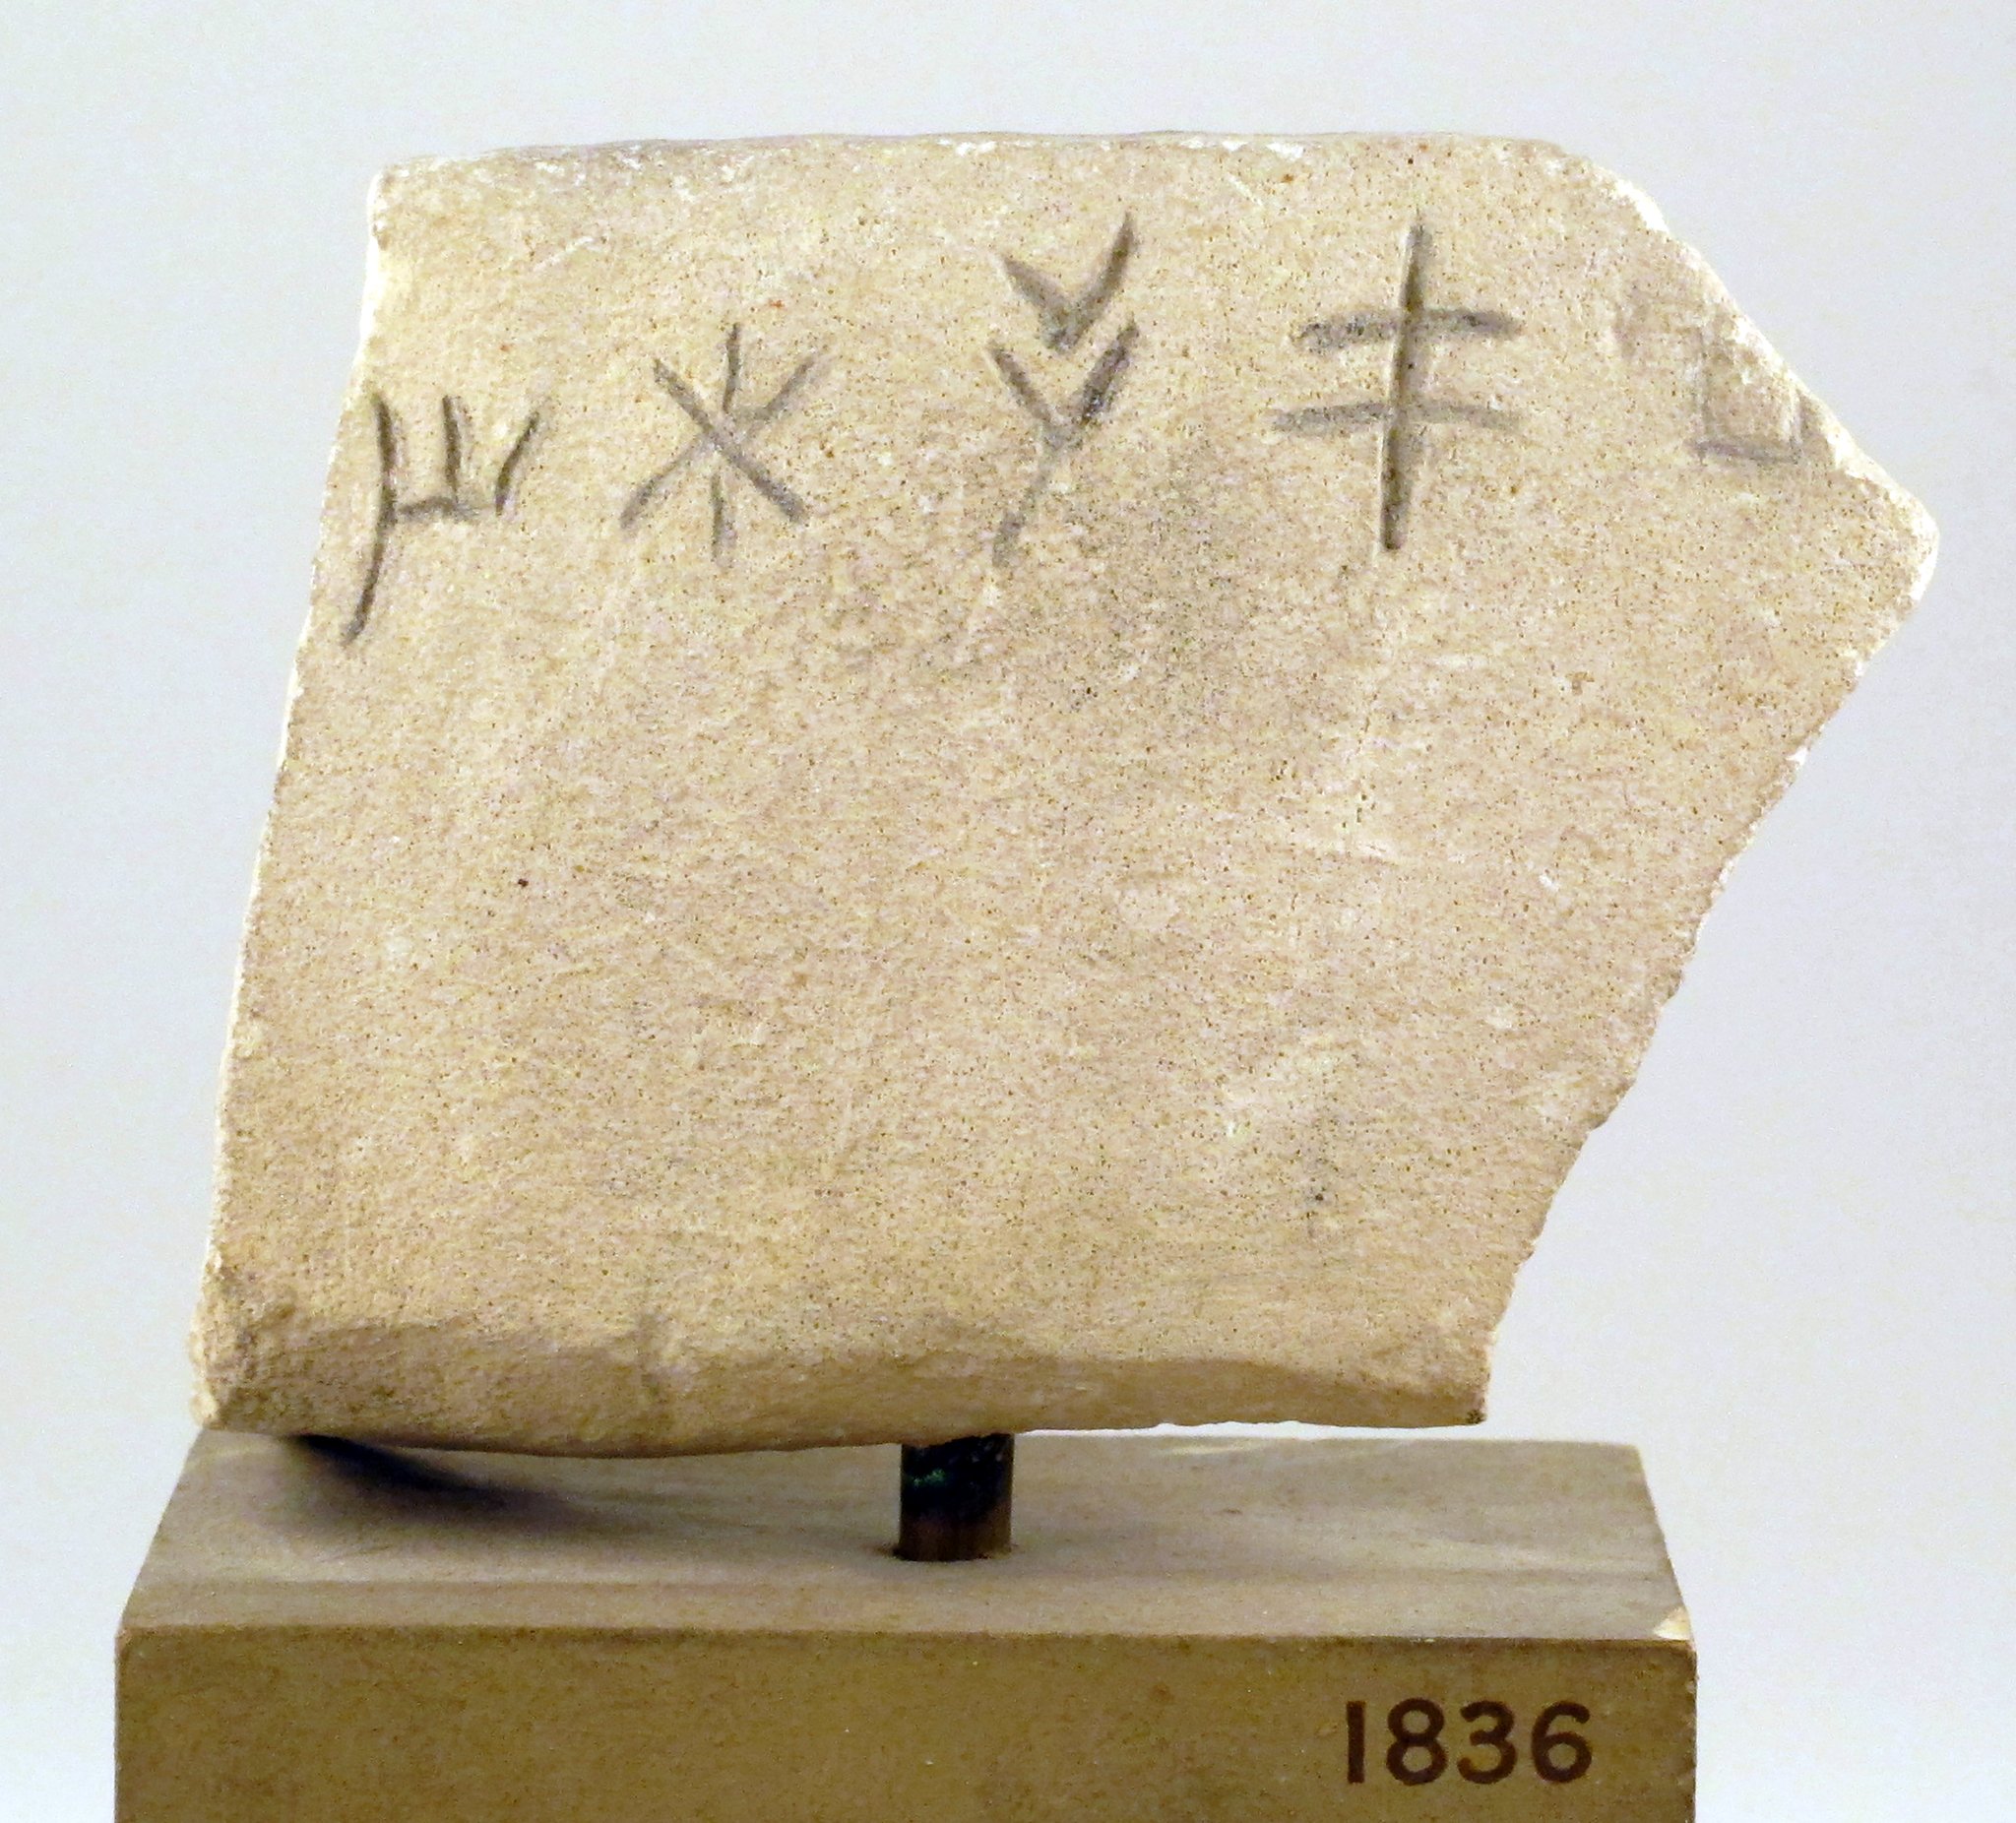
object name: box, inscribed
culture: cypriot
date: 3900 BCE-100 CE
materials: limestone